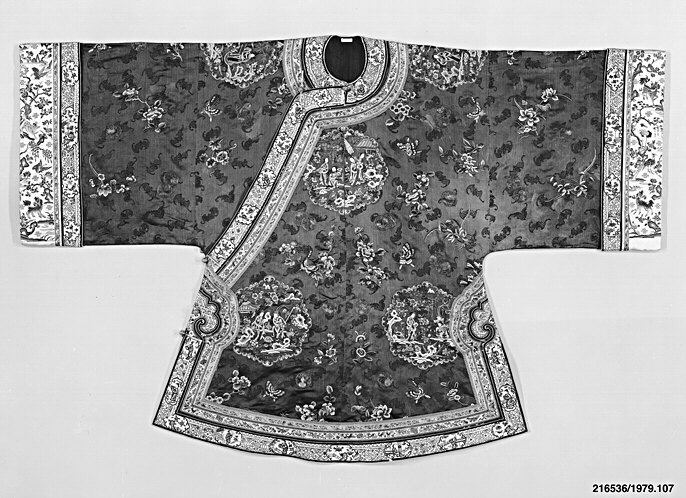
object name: woman's informal robe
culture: chinese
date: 1867-1933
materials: metal thread, silk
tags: bats